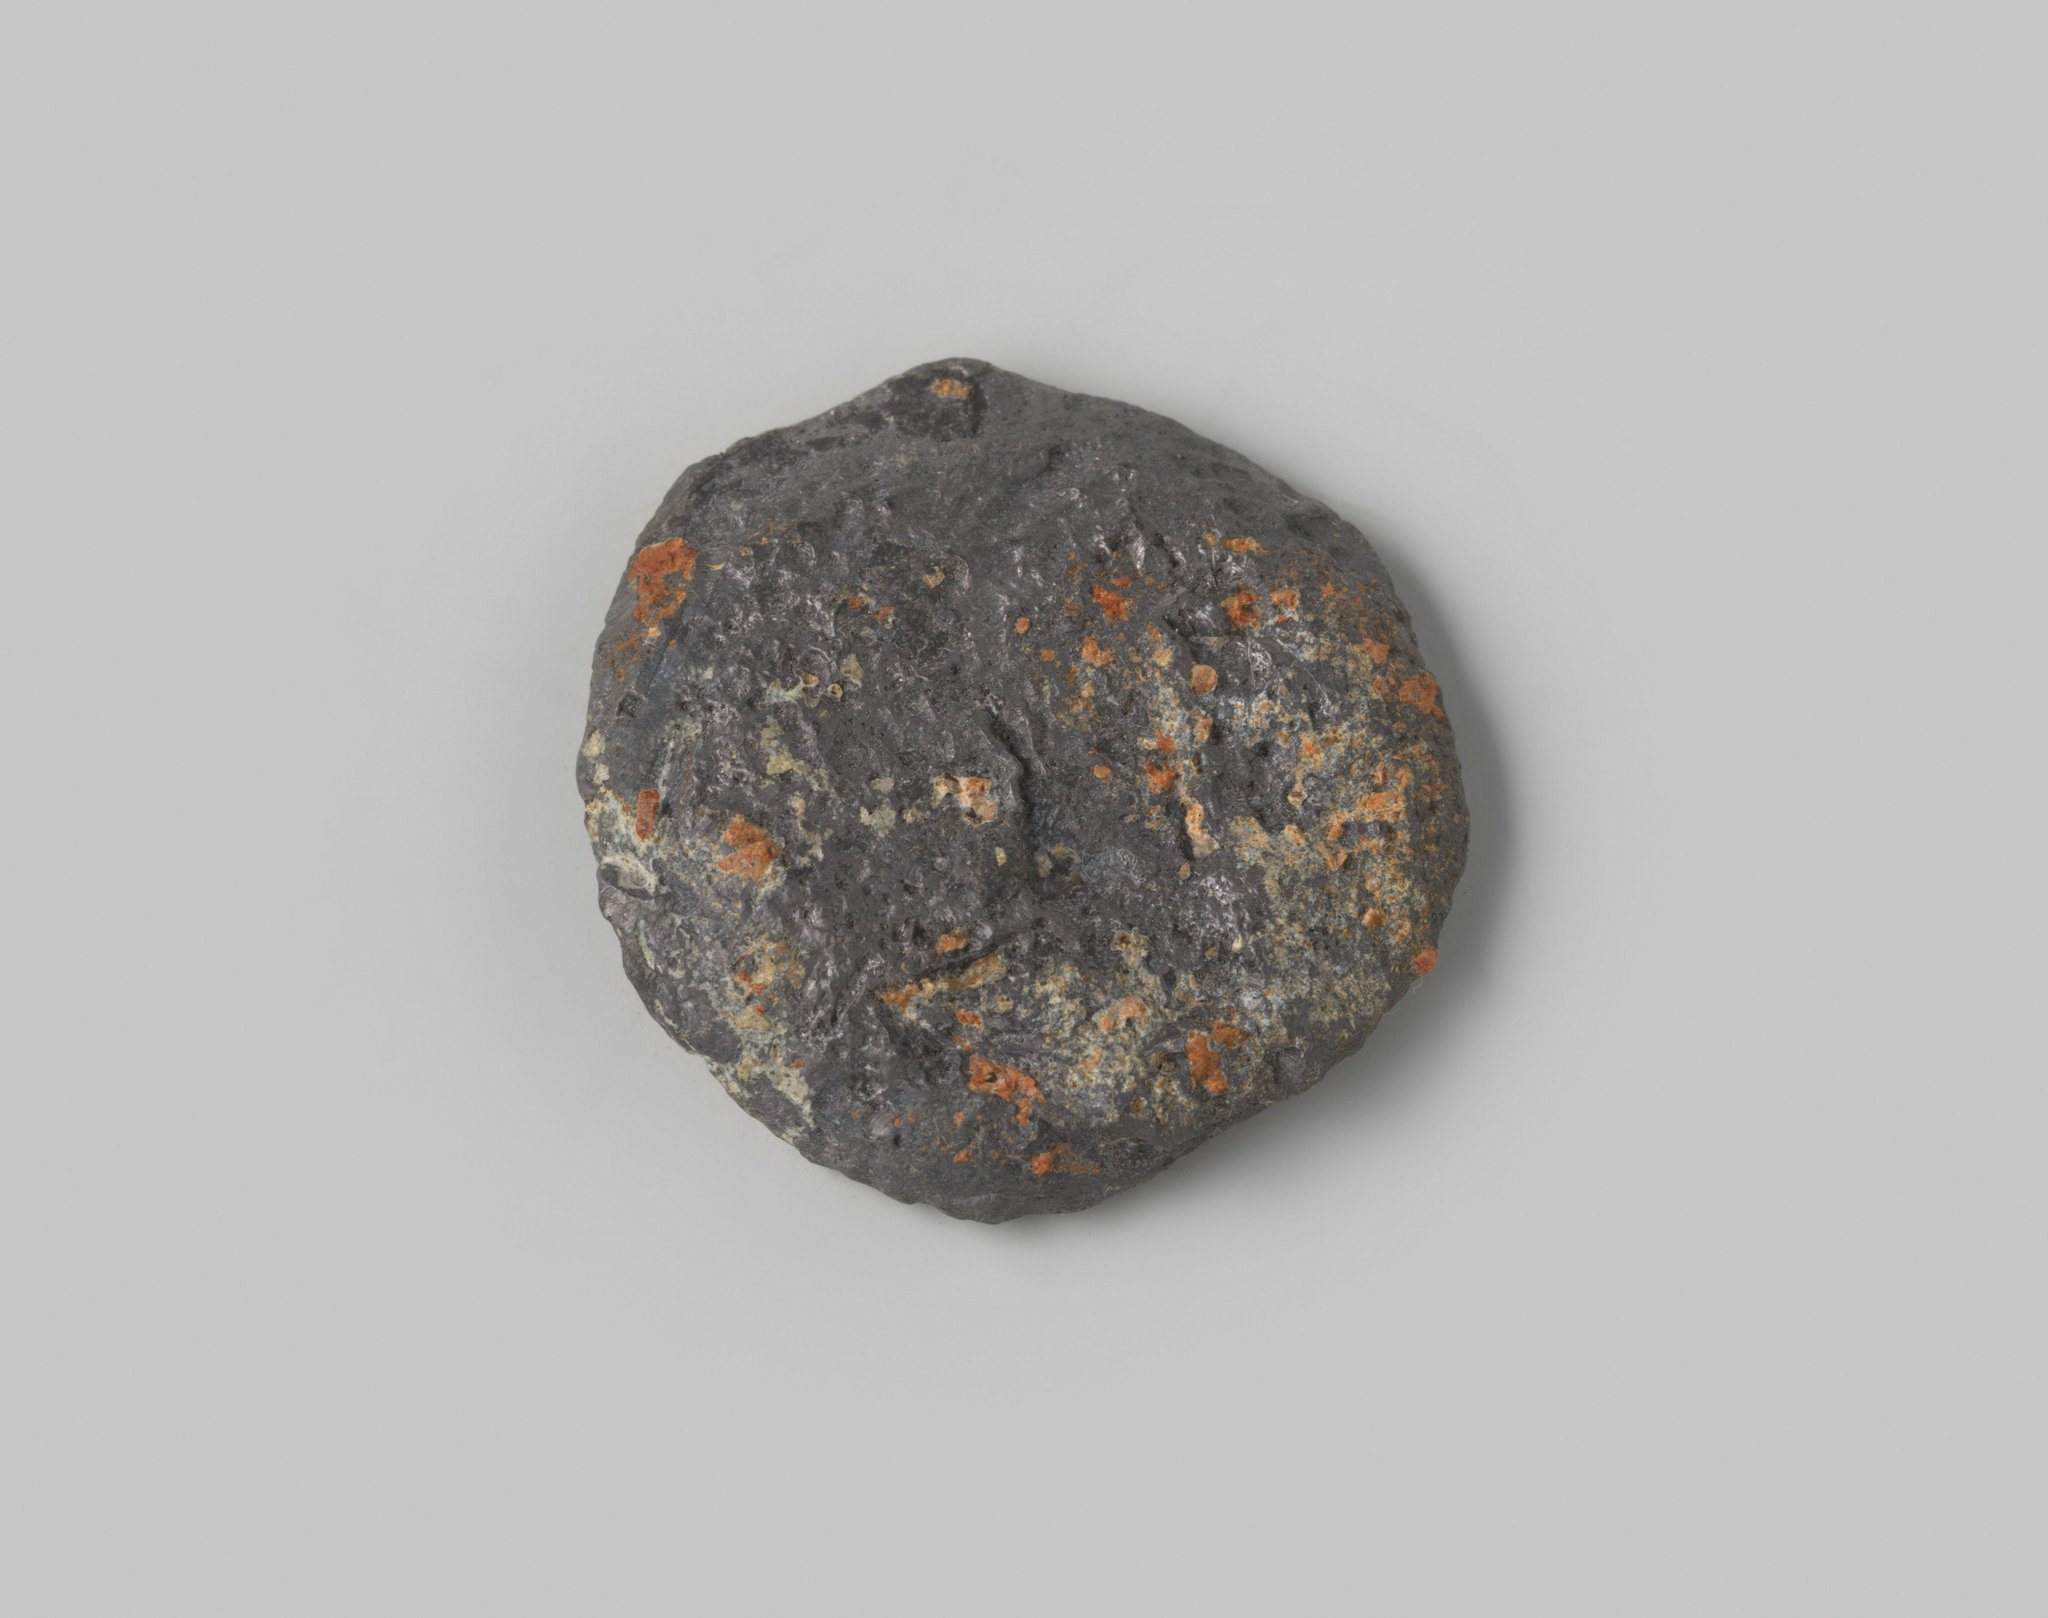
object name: weight scale component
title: Gewicht uit het wrak van de Oost-Indiëvaarder Hollandia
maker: Anonymous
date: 1700-1743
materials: lead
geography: netherlands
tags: verenigde oostindische compagnie, hollandia (schip), annet